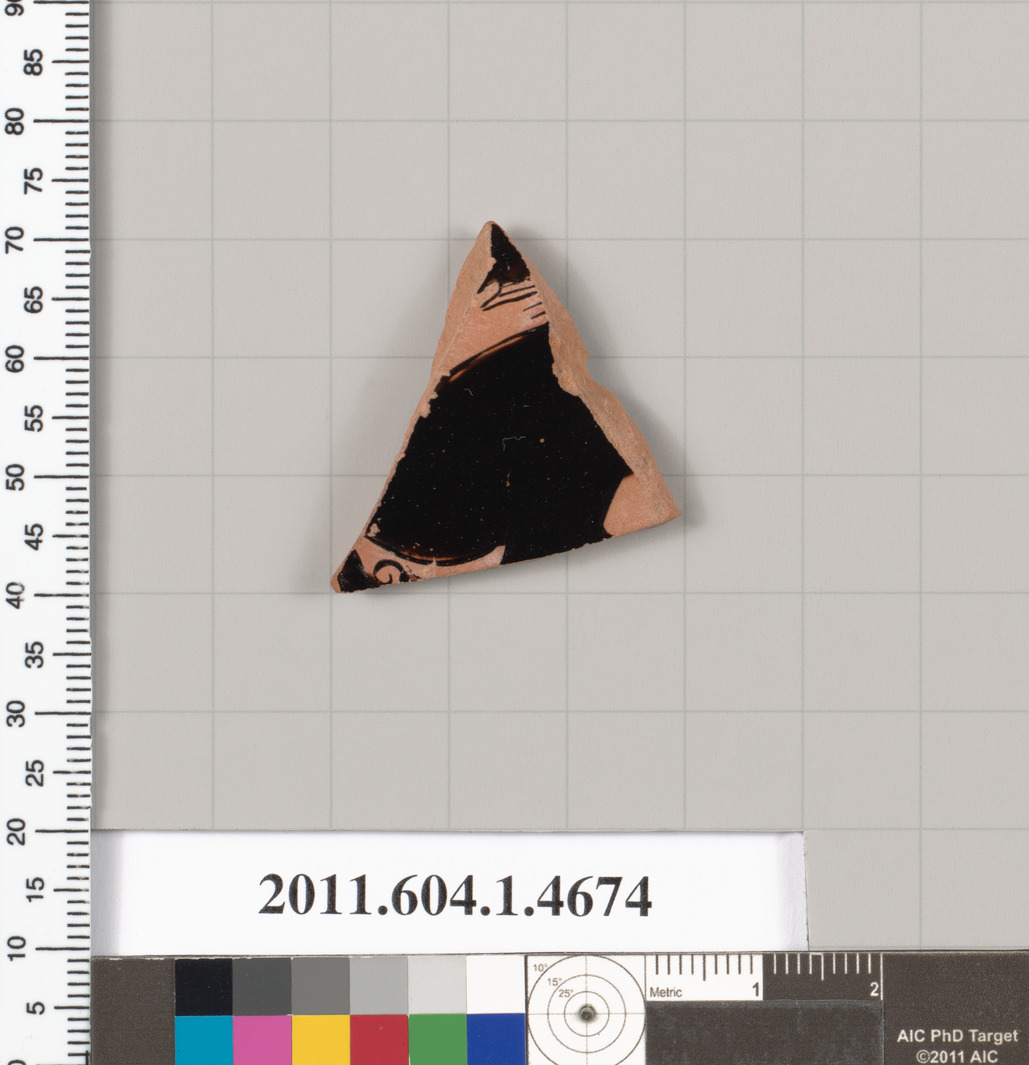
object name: kylix fragment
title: Terracotta fragment of a kylix (drinking cup)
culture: greek, attic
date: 480-470 BCE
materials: terracotta